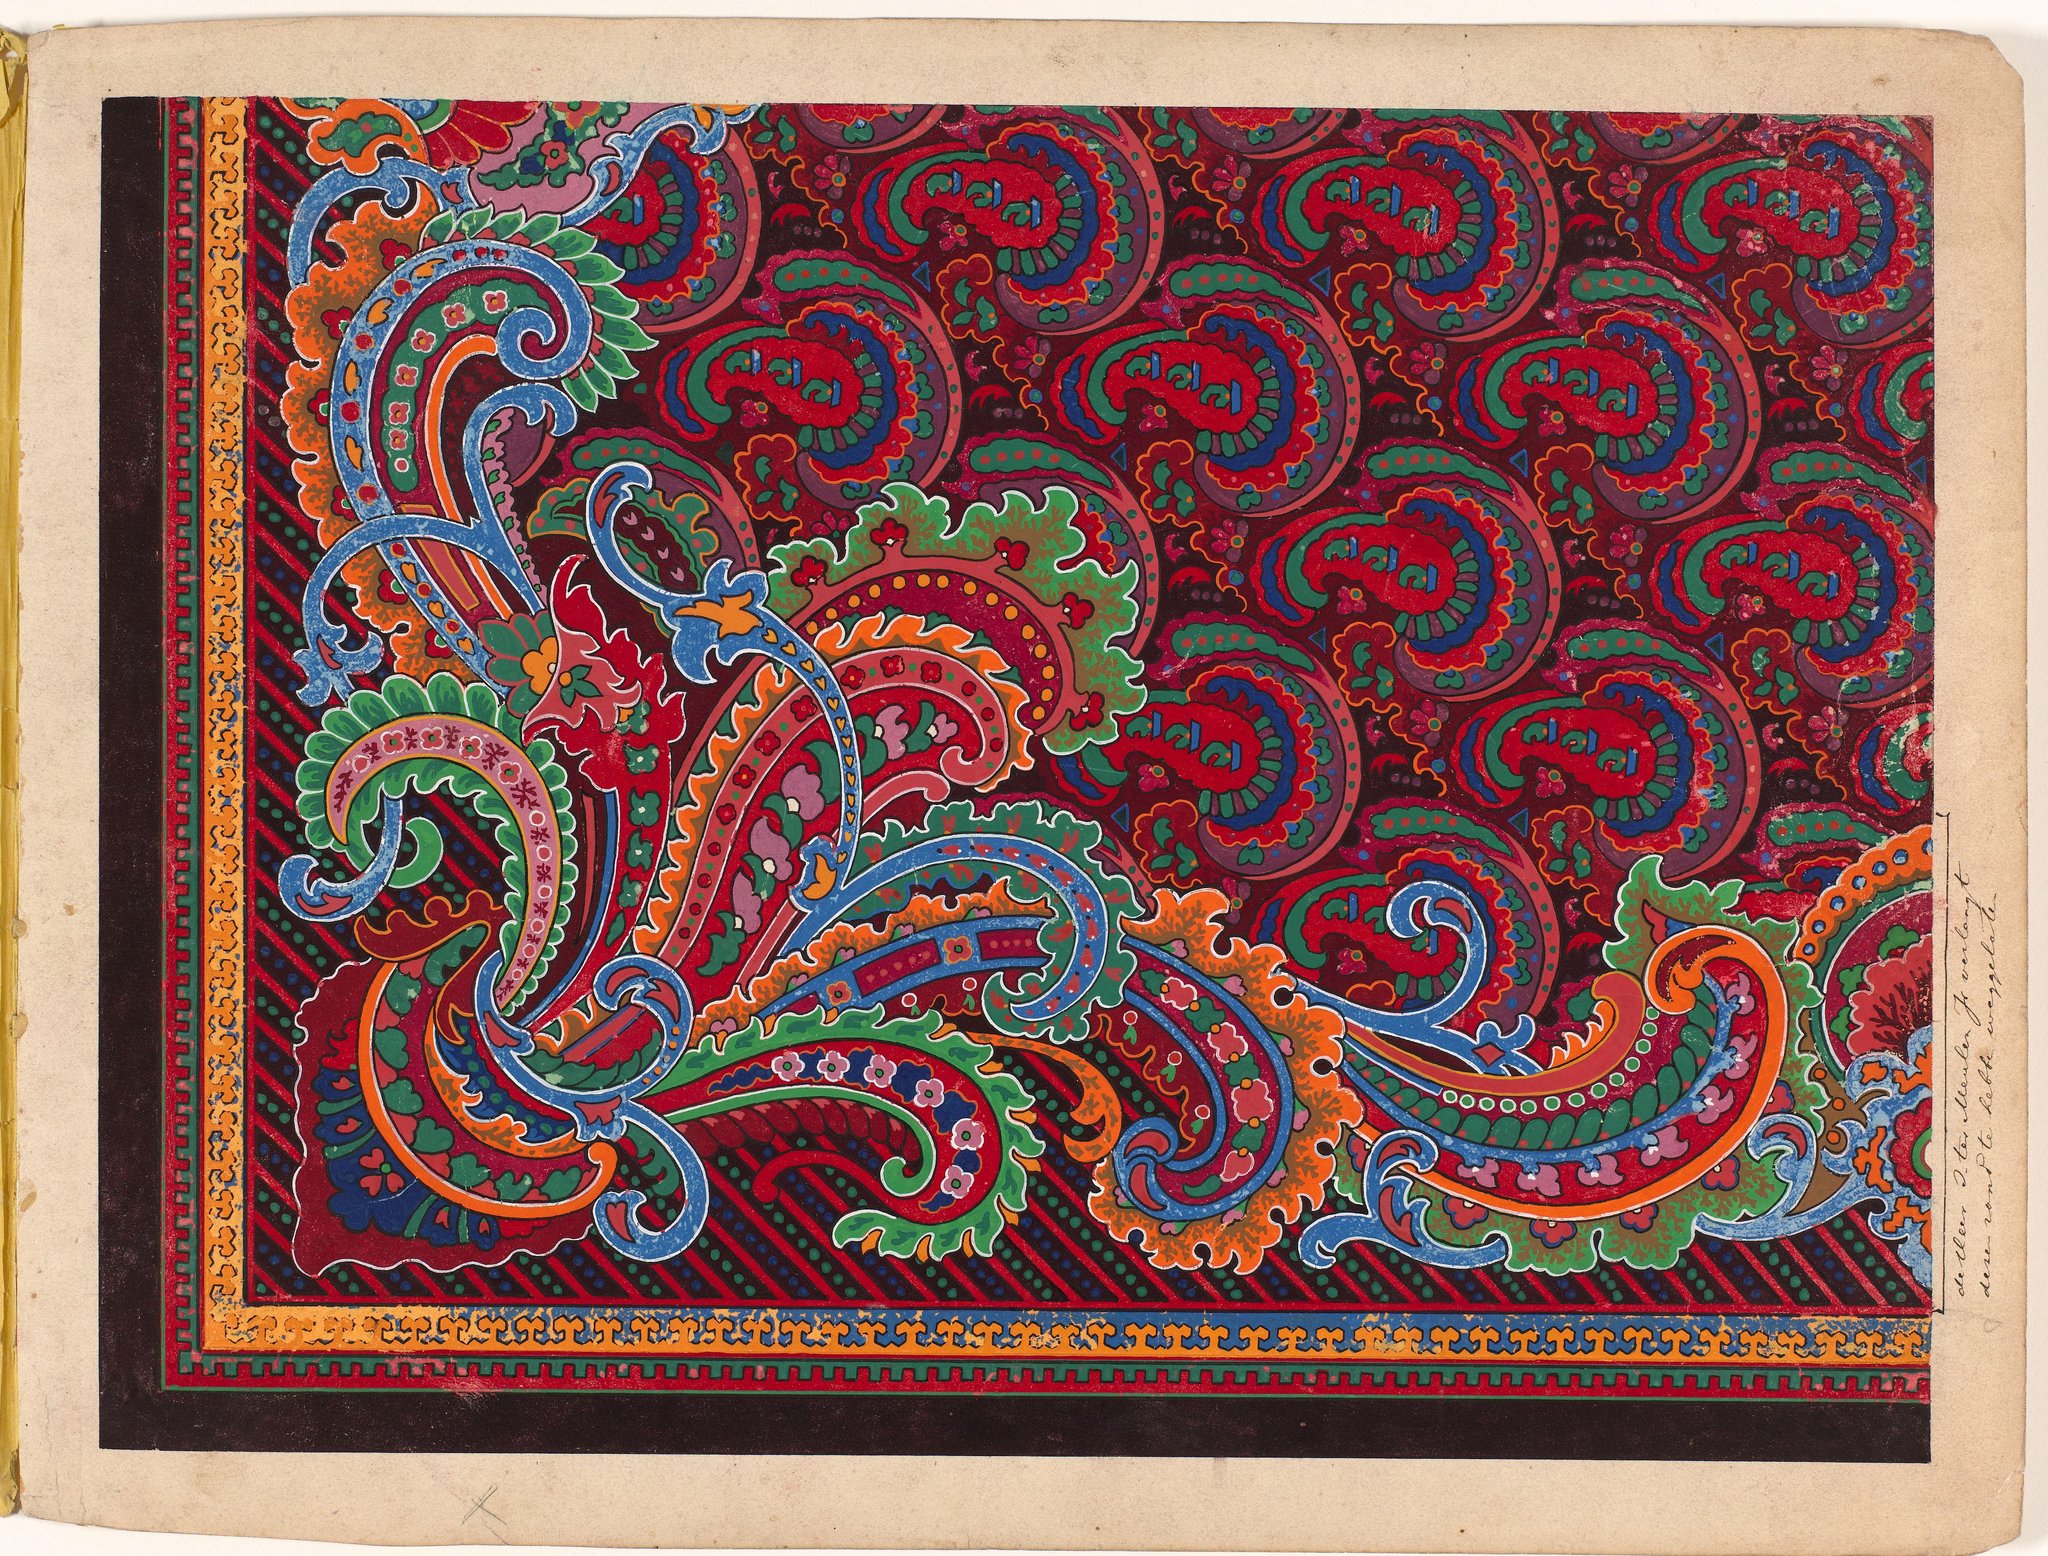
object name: design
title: Ontwerp voor een tapijt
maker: Anonymous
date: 1854-1864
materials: gouache, paper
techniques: brush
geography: deventer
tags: ornaments ~ art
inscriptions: retailer's mark: ‘JHS.’, inscription: ‘in de Rand/ R. Bartelo (...) teekening gevolgd worden’, inscription: ‘de Heer J. ter Meulen Jr. verlangt/ dezen rond te hebbe weggelaten’, number: ‘No 62.ii/ Zijnde Rand 35.ii/ en Binnenwerk 420’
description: De presentatietekeningen BK-1971-77-1 t/m 86 zijn kopieën van de originele ontwerptekeningen. Ze werden gemaakt voor vertegenwoordigers van bijvoorbeeld magazijnen, die ze aan hun klanten konden tonen. De meeste tekeningen tonen een kwart van het dessin inclusief rand, middenpartij (de zogenaamde grond of fond) en centraal medaillon. Door het gebruik van spiegels kan de illusie van het gehele tapijt worden opgeroepen. Een deel van de tekeningen heeft een alfabetische opeenvolgende letter als kenmerk, de andere groep een cijfer.Waarschijnlijk is de reeks dessins met een letter eerder samengesteld dan de genummerde tekeningen.